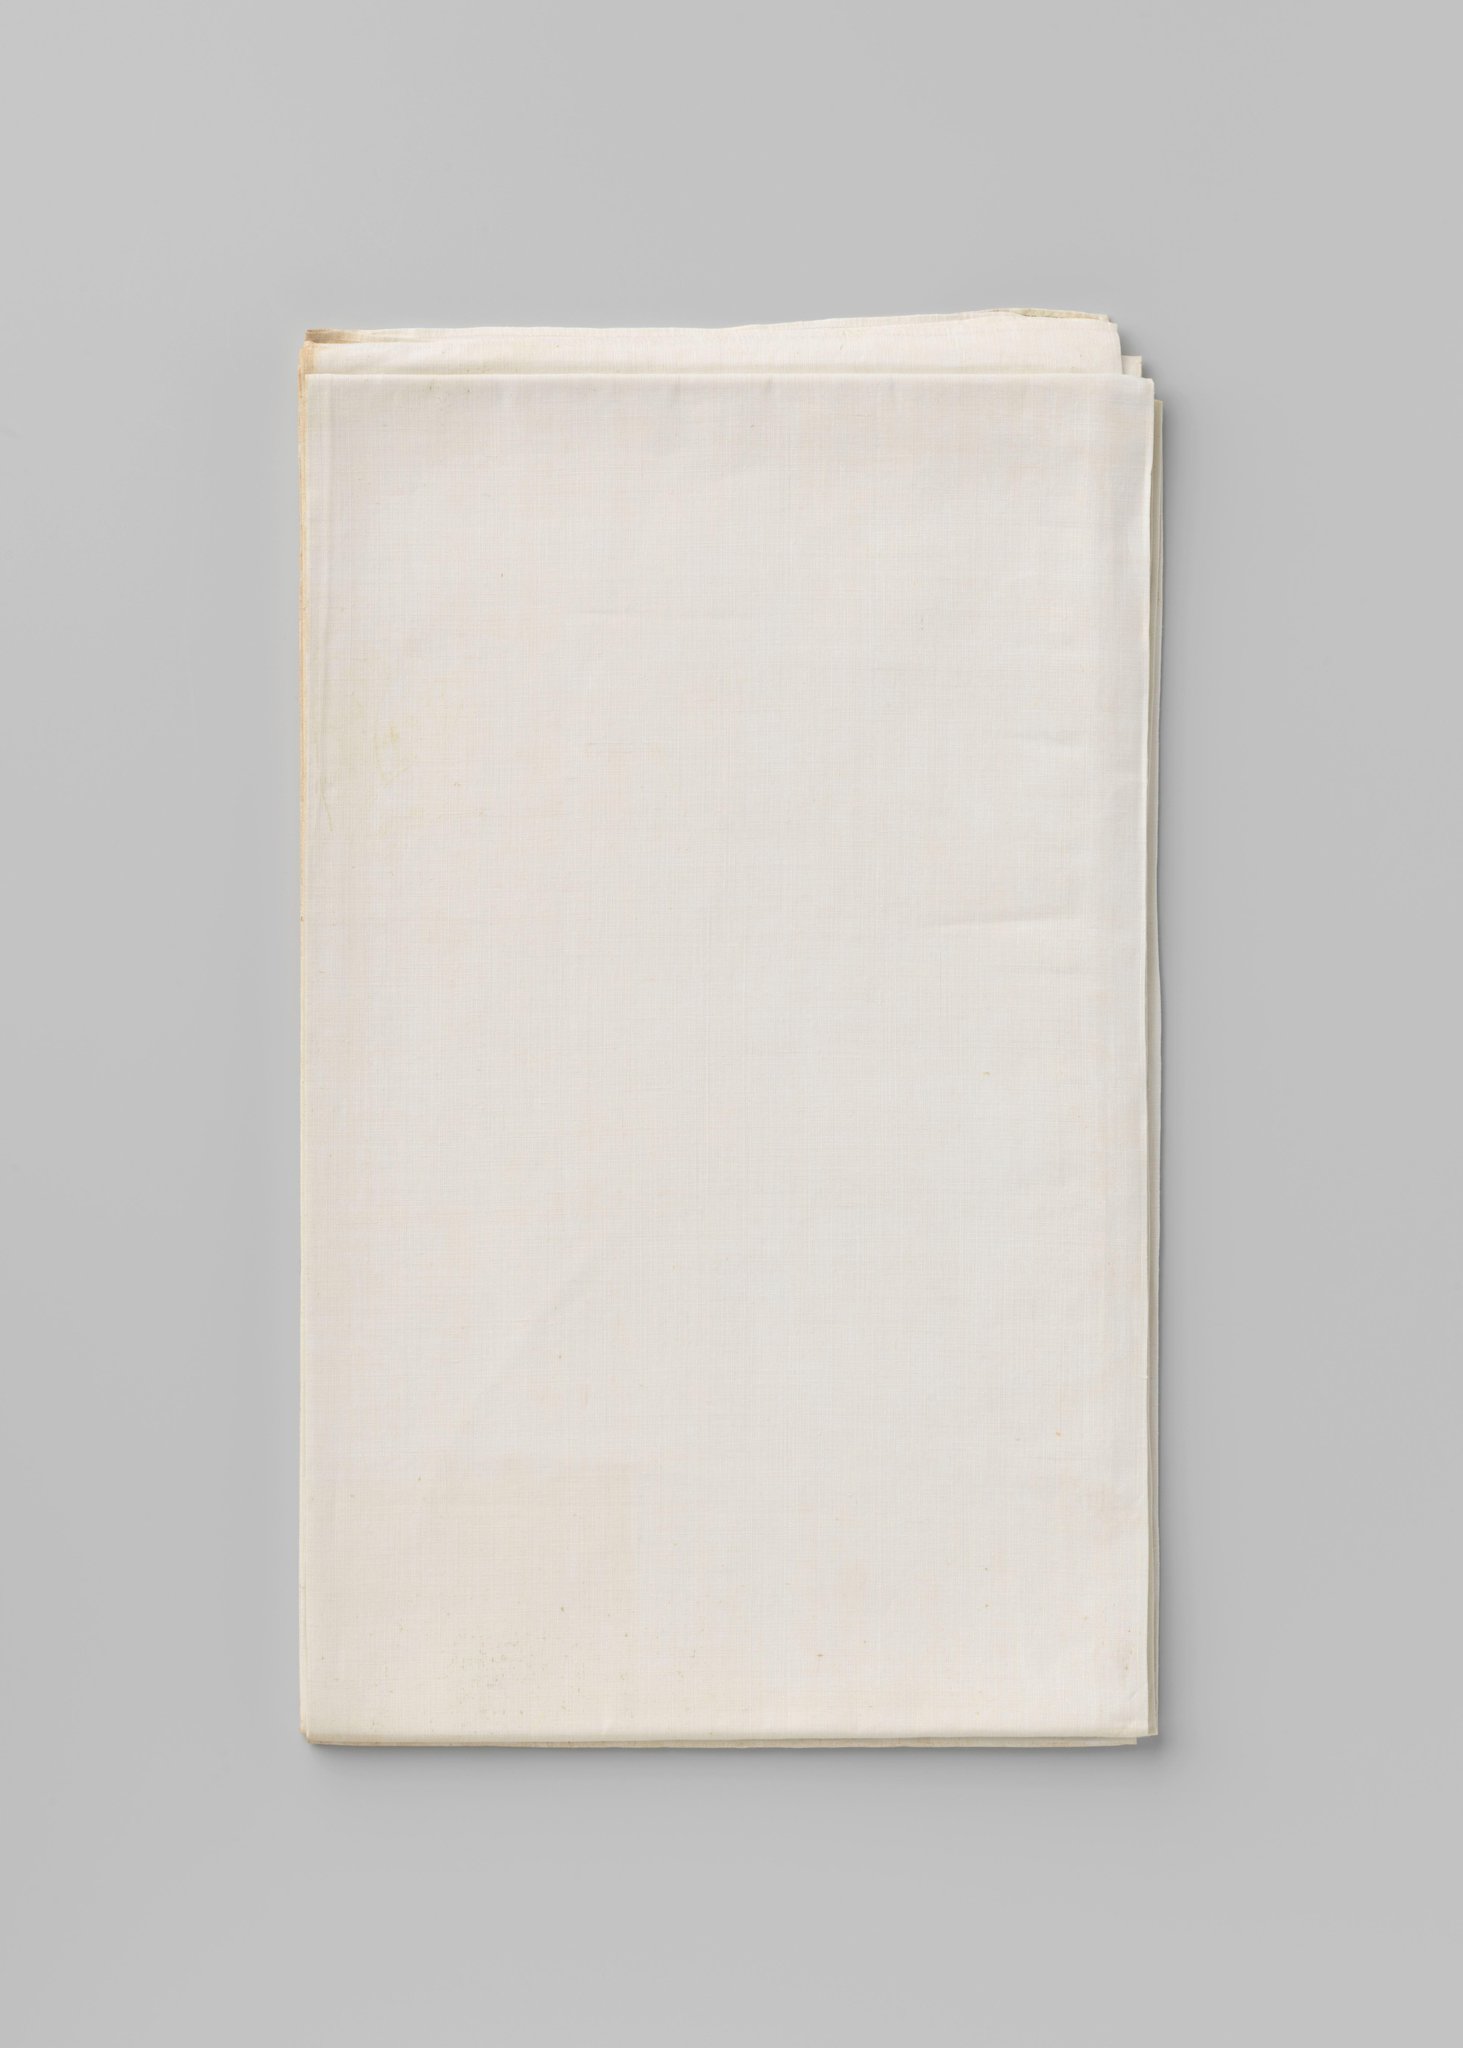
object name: beddenlaken, laken object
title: Laken. Merk onleesbaar.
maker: Anonymous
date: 1650-1750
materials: linen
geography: northern netherlands